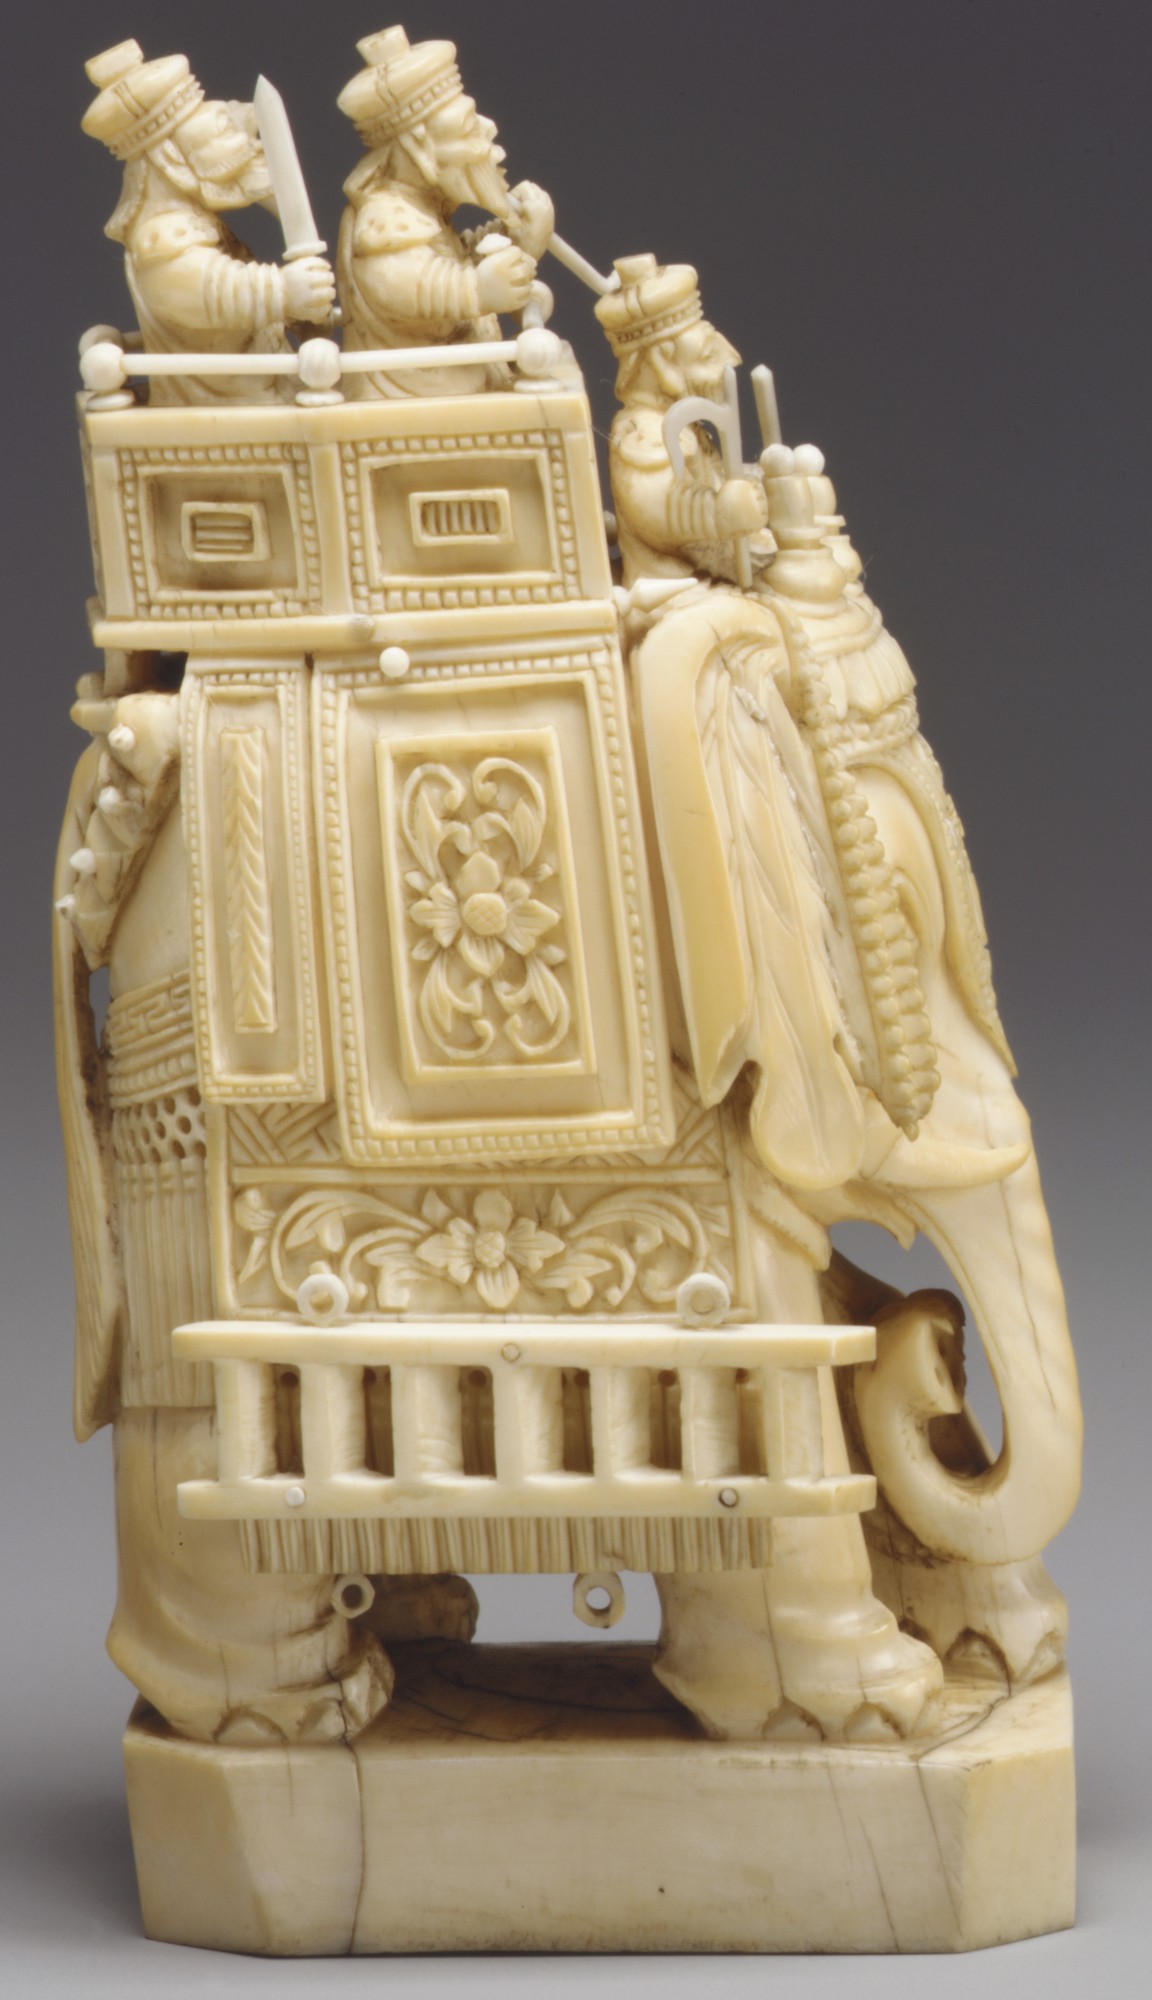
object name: chessman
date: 1801-1900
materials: ivory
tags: chess,elephants,games